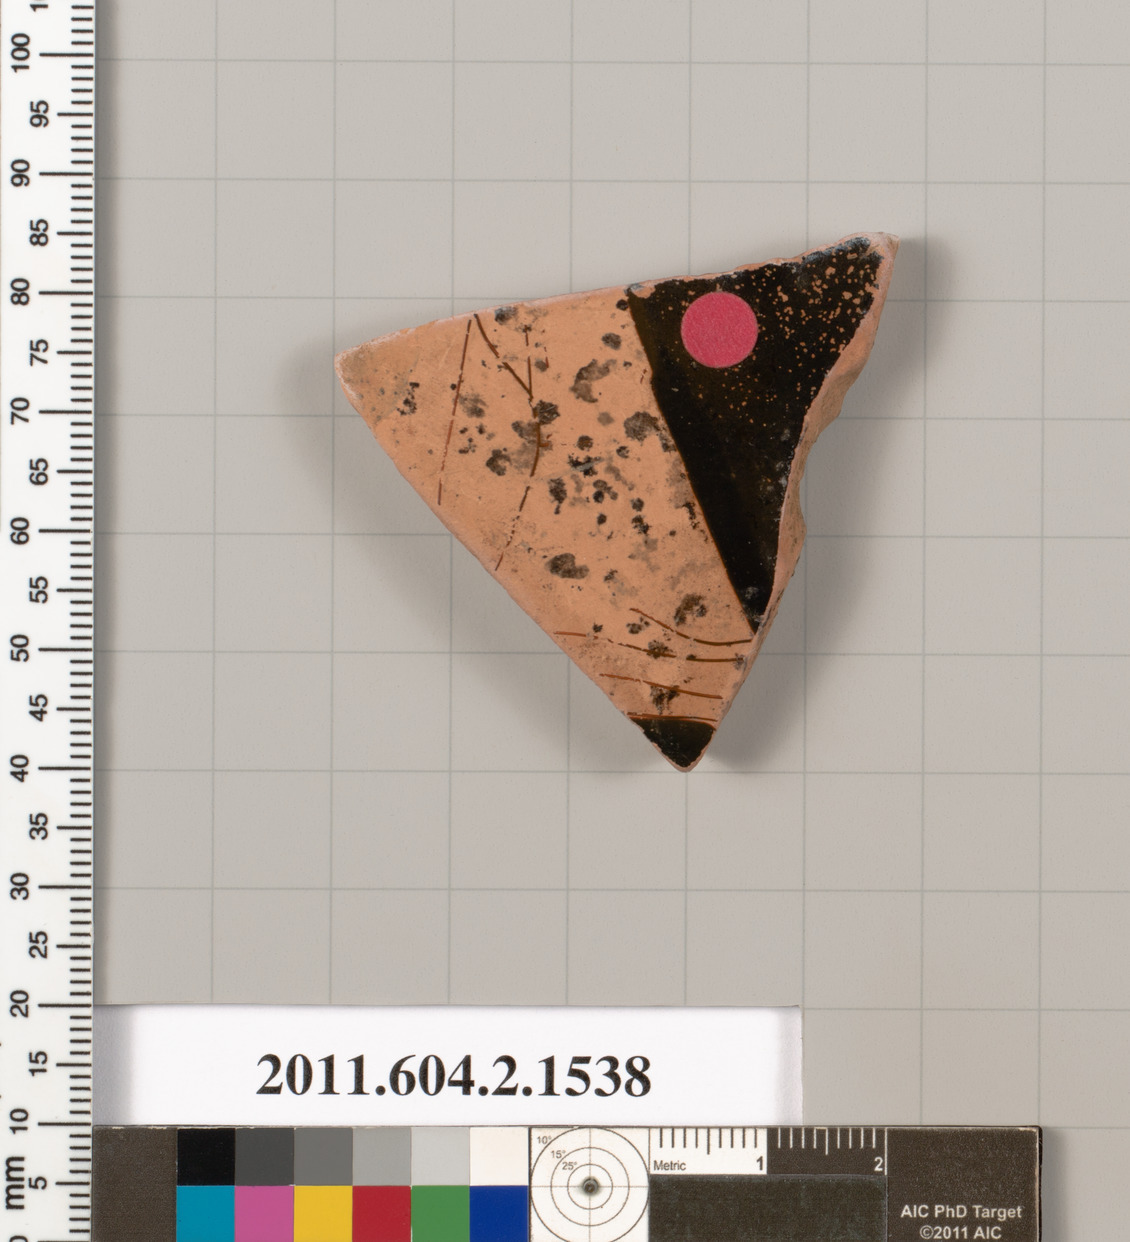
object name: skyphos fragment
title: Terracotta fragment of a skyphos (deep drinking cup)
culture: greek, attic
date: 460-440 BCE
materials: terracotta